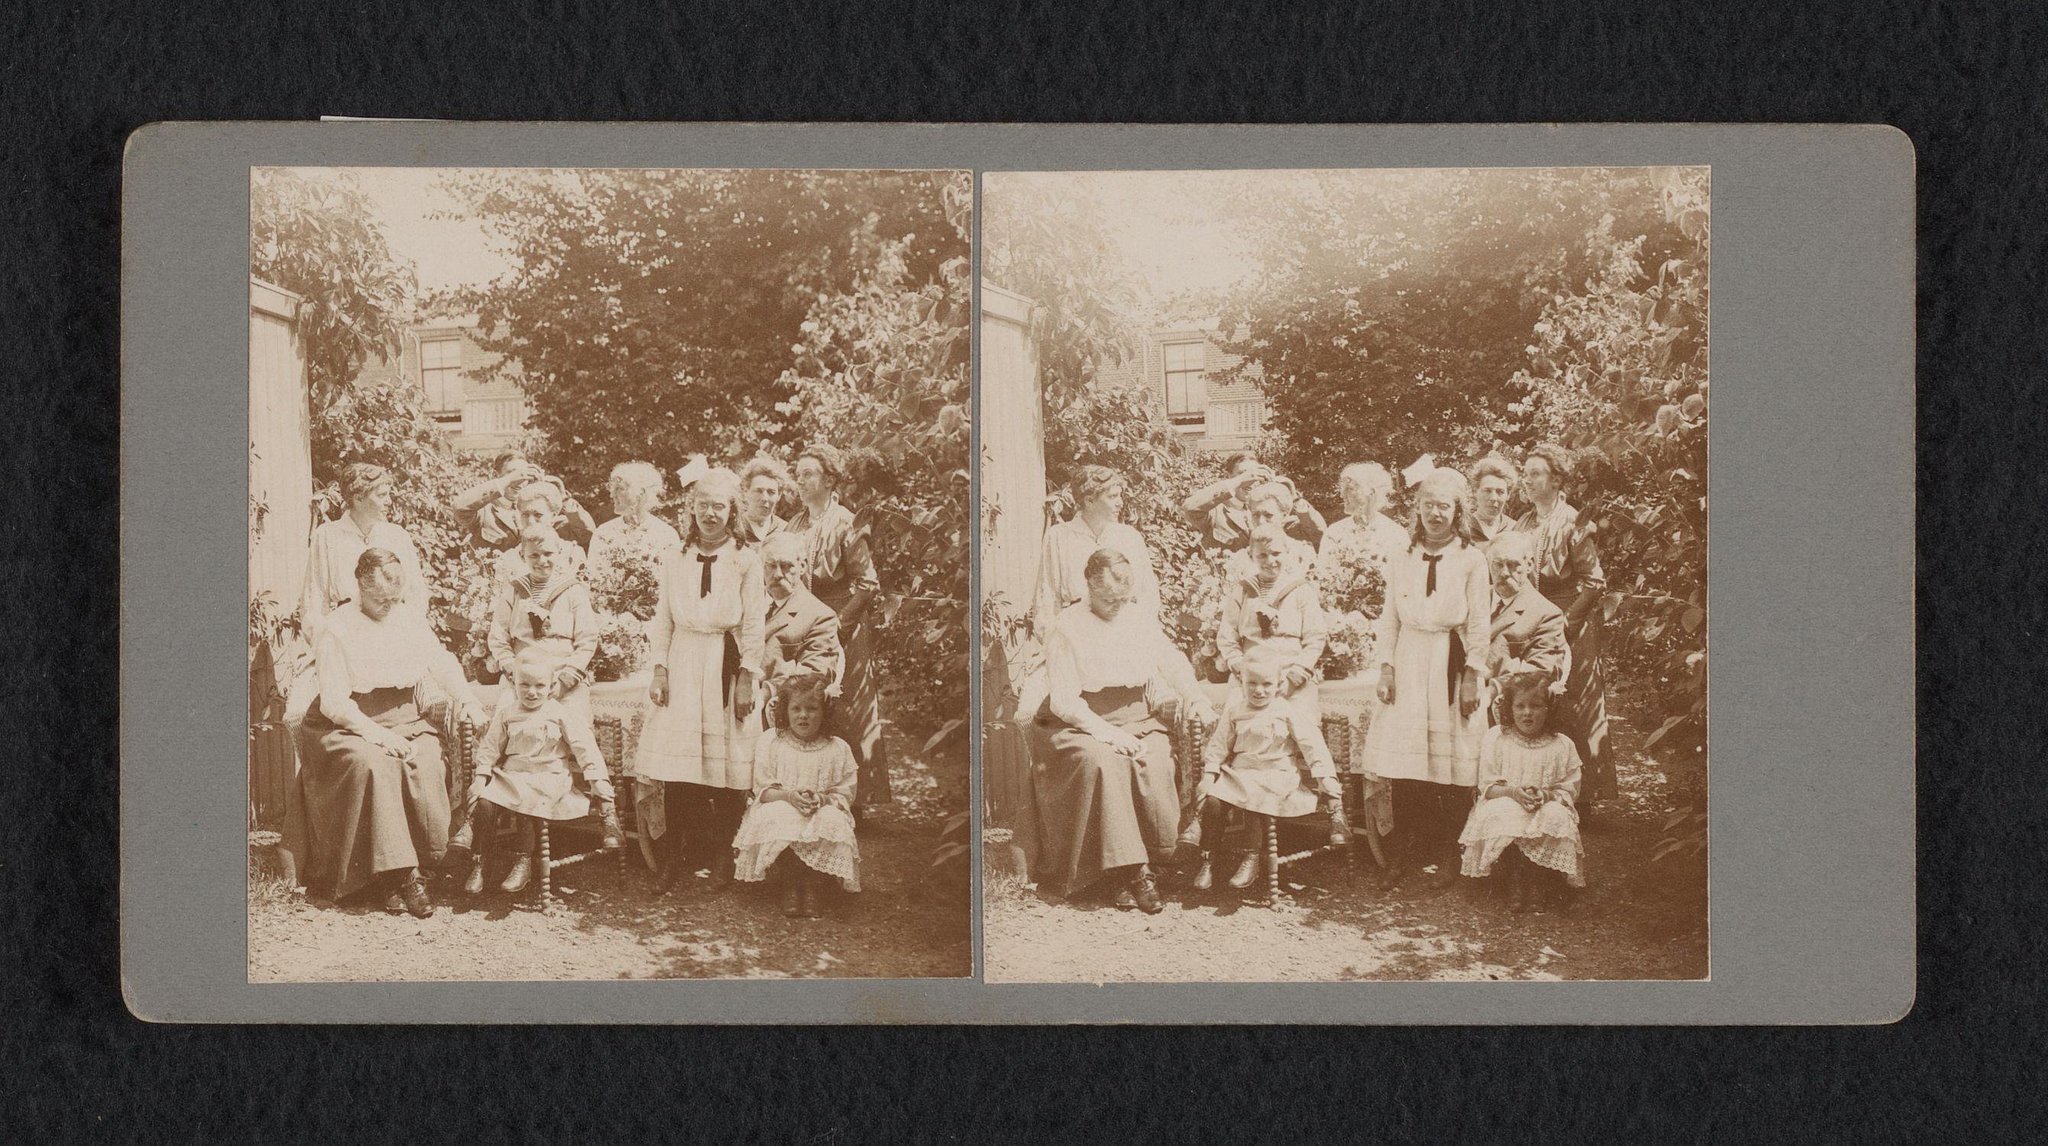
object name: stereograph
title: Groepsportret van de familie Suyver en echtgenoten in de tuin van Herengracht 6 te Amsterdam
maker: machiel gerrit george suyver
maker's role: fotograaf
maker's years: 1872-1933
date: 1916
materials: paper, cardboard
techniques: collodion silver print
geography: netherlands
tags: amsterdam, rotterdam, family group, especially parents with their child(ren), garden, historical persons